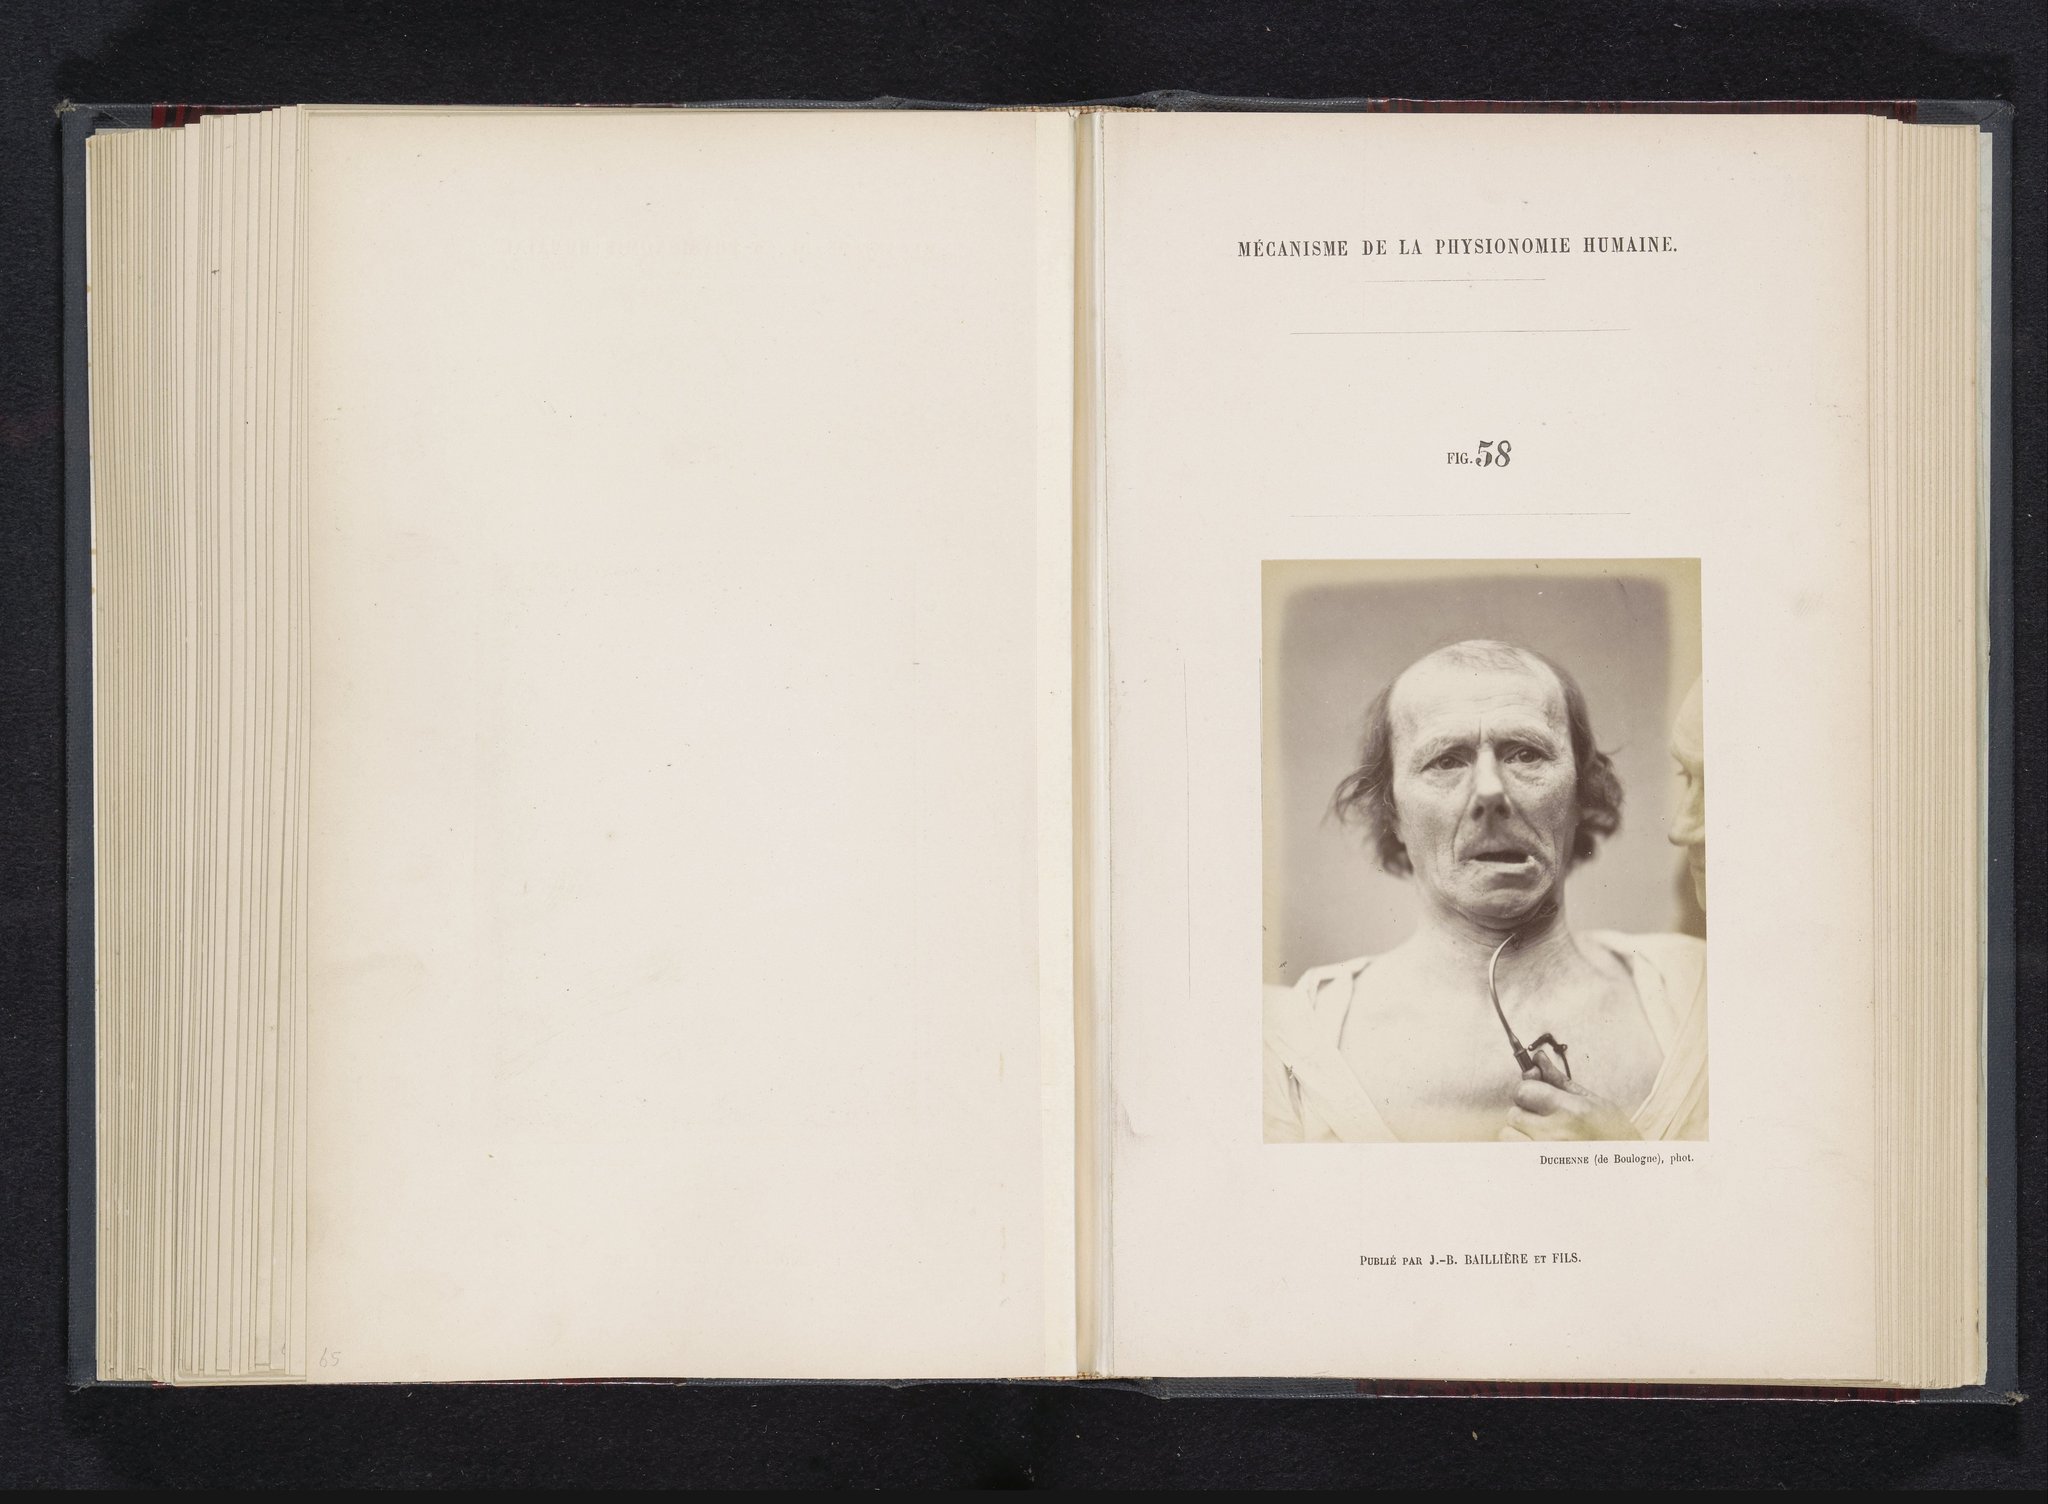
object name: page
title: Portret van een proefpersoon tijdens elektrostimulatie: 'un vieillard'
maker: guillaume benjamin amand duchenne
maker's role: fotograaf, medicus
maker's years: 1806-1875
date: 1860-1862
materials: paper, photographic support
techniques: albumen print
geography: france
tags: face, physiology and anatomy ~ nervous system, neurology, physiology and anatomy, old man, morphology of facial expression, physiognomy, experiment, test ~ science and technology, france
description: Ongenummerde pagina met foto 58 uit Mécanisme de la physionomie humaine ou analyse électro-physiologique de l'expression des passions (Atlas).